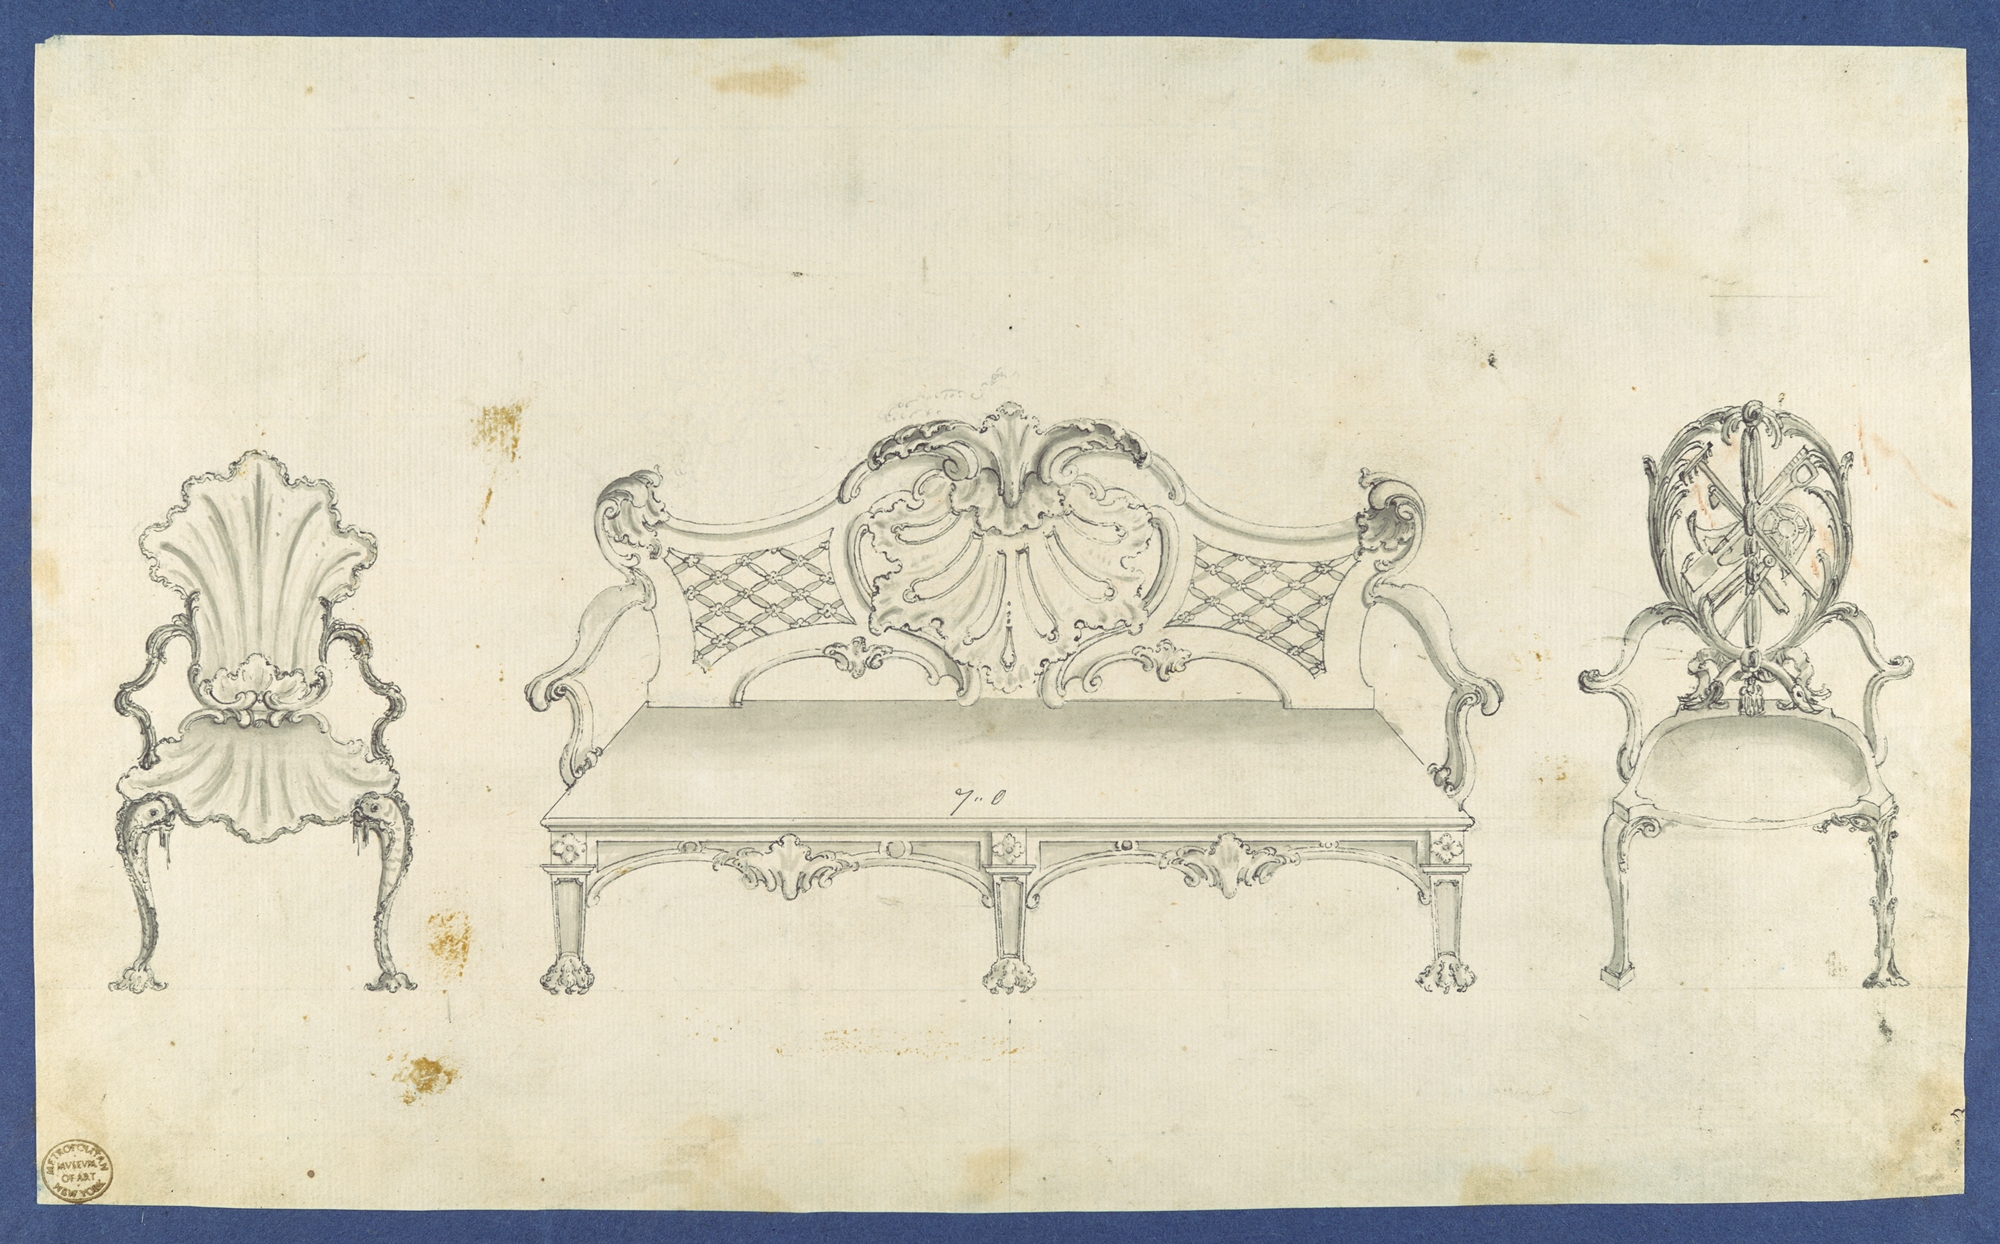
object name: drawing ornament architecture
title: Two Garden Chairs and Long Seat, in Chippendale Drawings, Vol. I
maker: thomas chippendale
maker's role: artist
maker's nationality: british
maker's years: 1718-1779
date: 1761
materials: ink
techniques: wash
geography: london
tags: chairs,couches